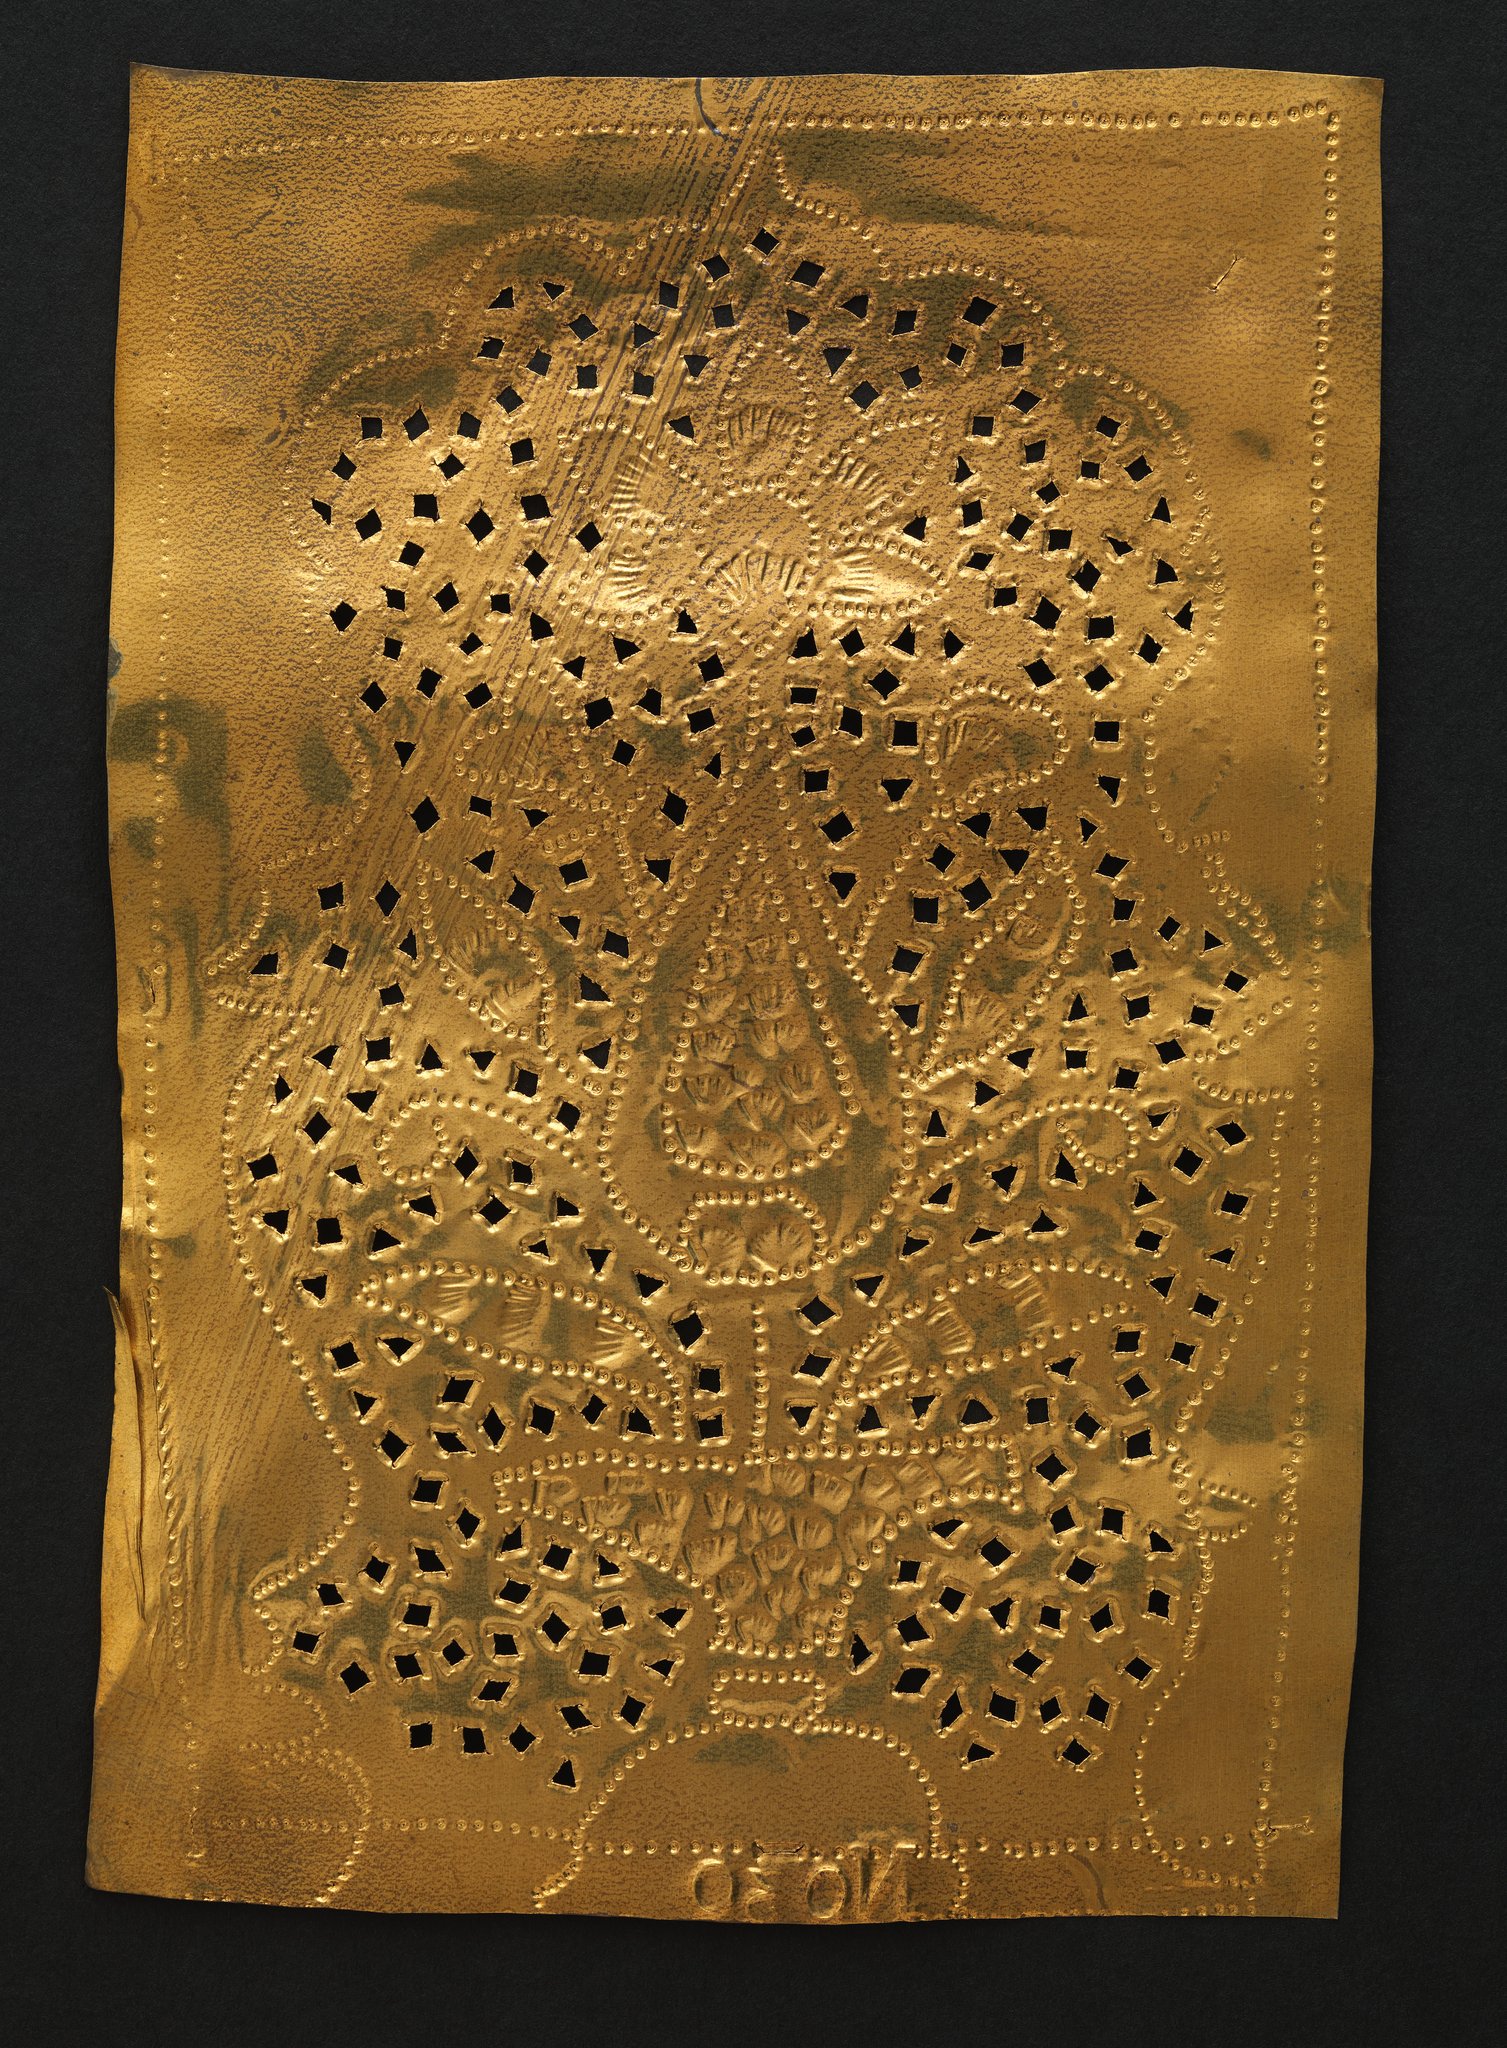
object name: cutout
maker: lockwood de forest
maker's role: designer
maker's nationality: american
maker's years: 1850-1932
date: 1892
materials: brass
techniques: chasing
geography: india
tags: flowers